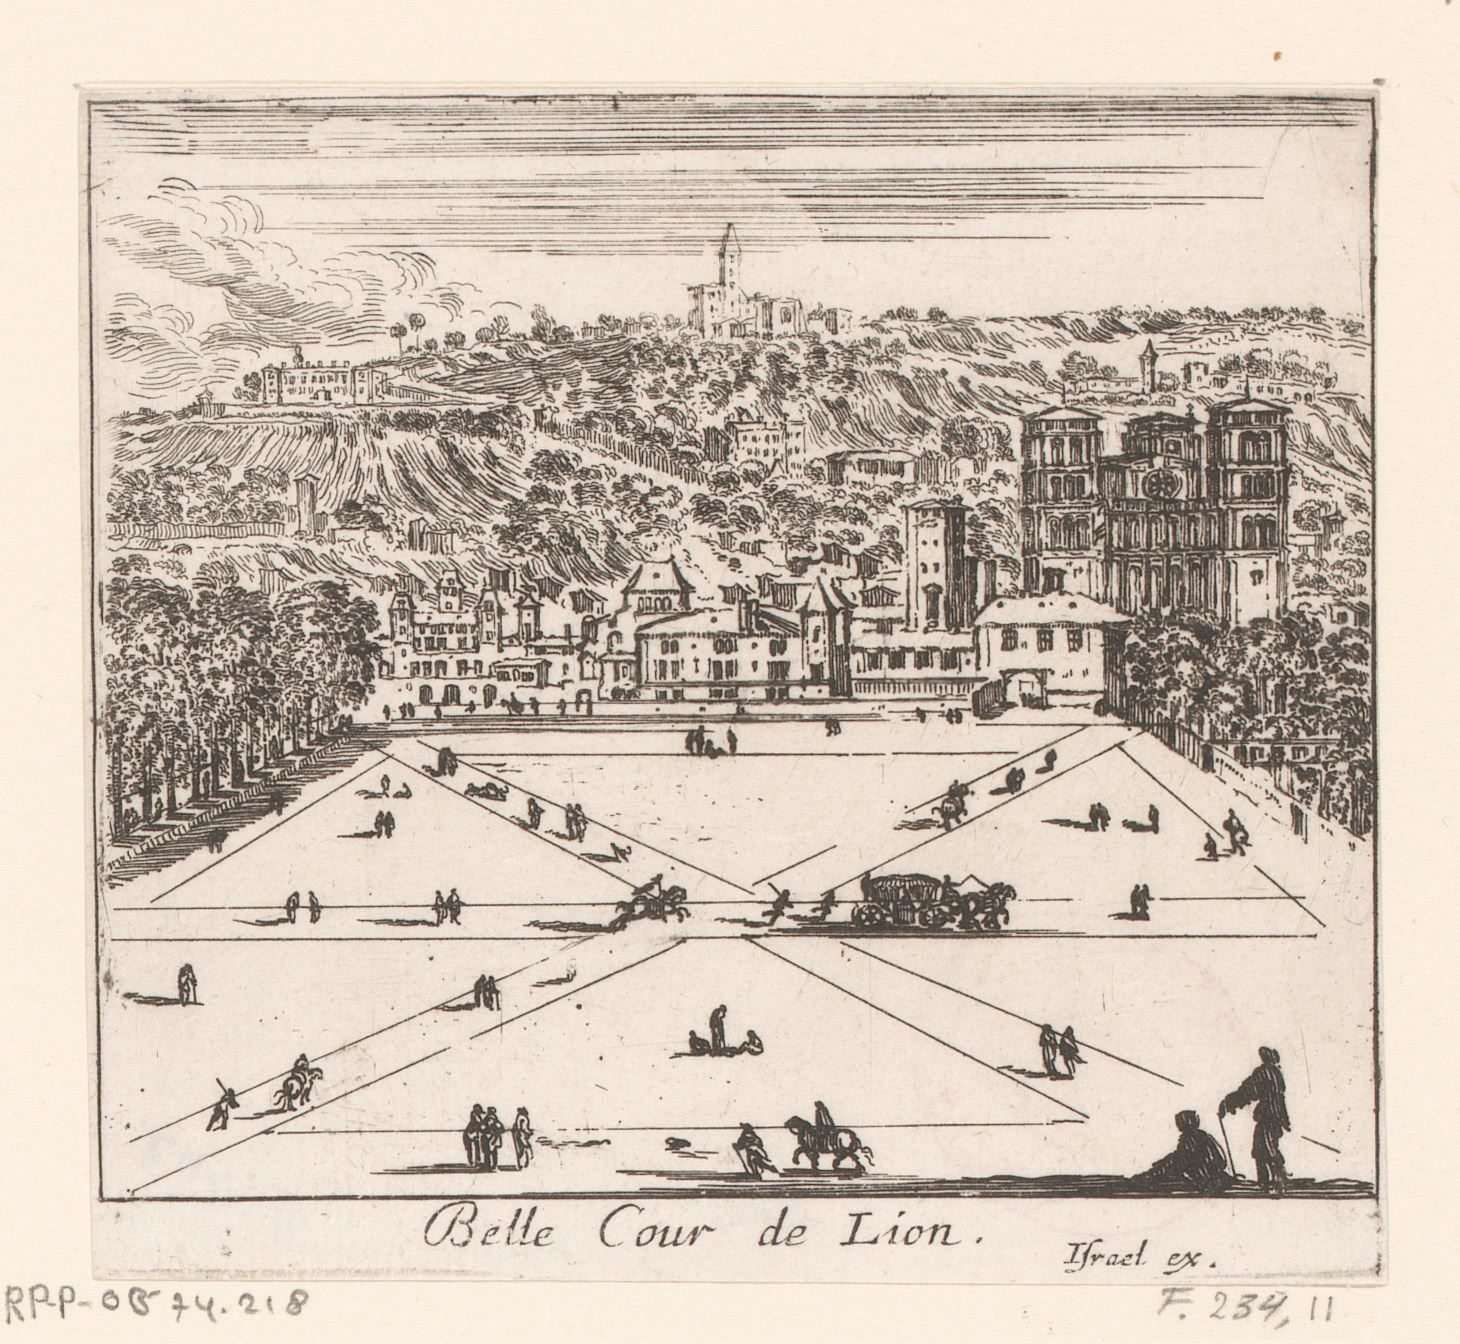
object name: print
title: Gezicht op Bellecourplein in Lyon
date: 1652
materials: paper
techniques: engraving, etching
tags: square, place, circus, etc., lyon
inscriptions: collector's mark: Lugt 240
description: Prent maakt deel uit van een ongenummerde serie van dertien prenten.